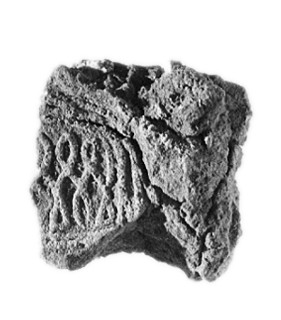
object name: sealing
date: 1981-1640 BCE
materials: mud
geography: egypt